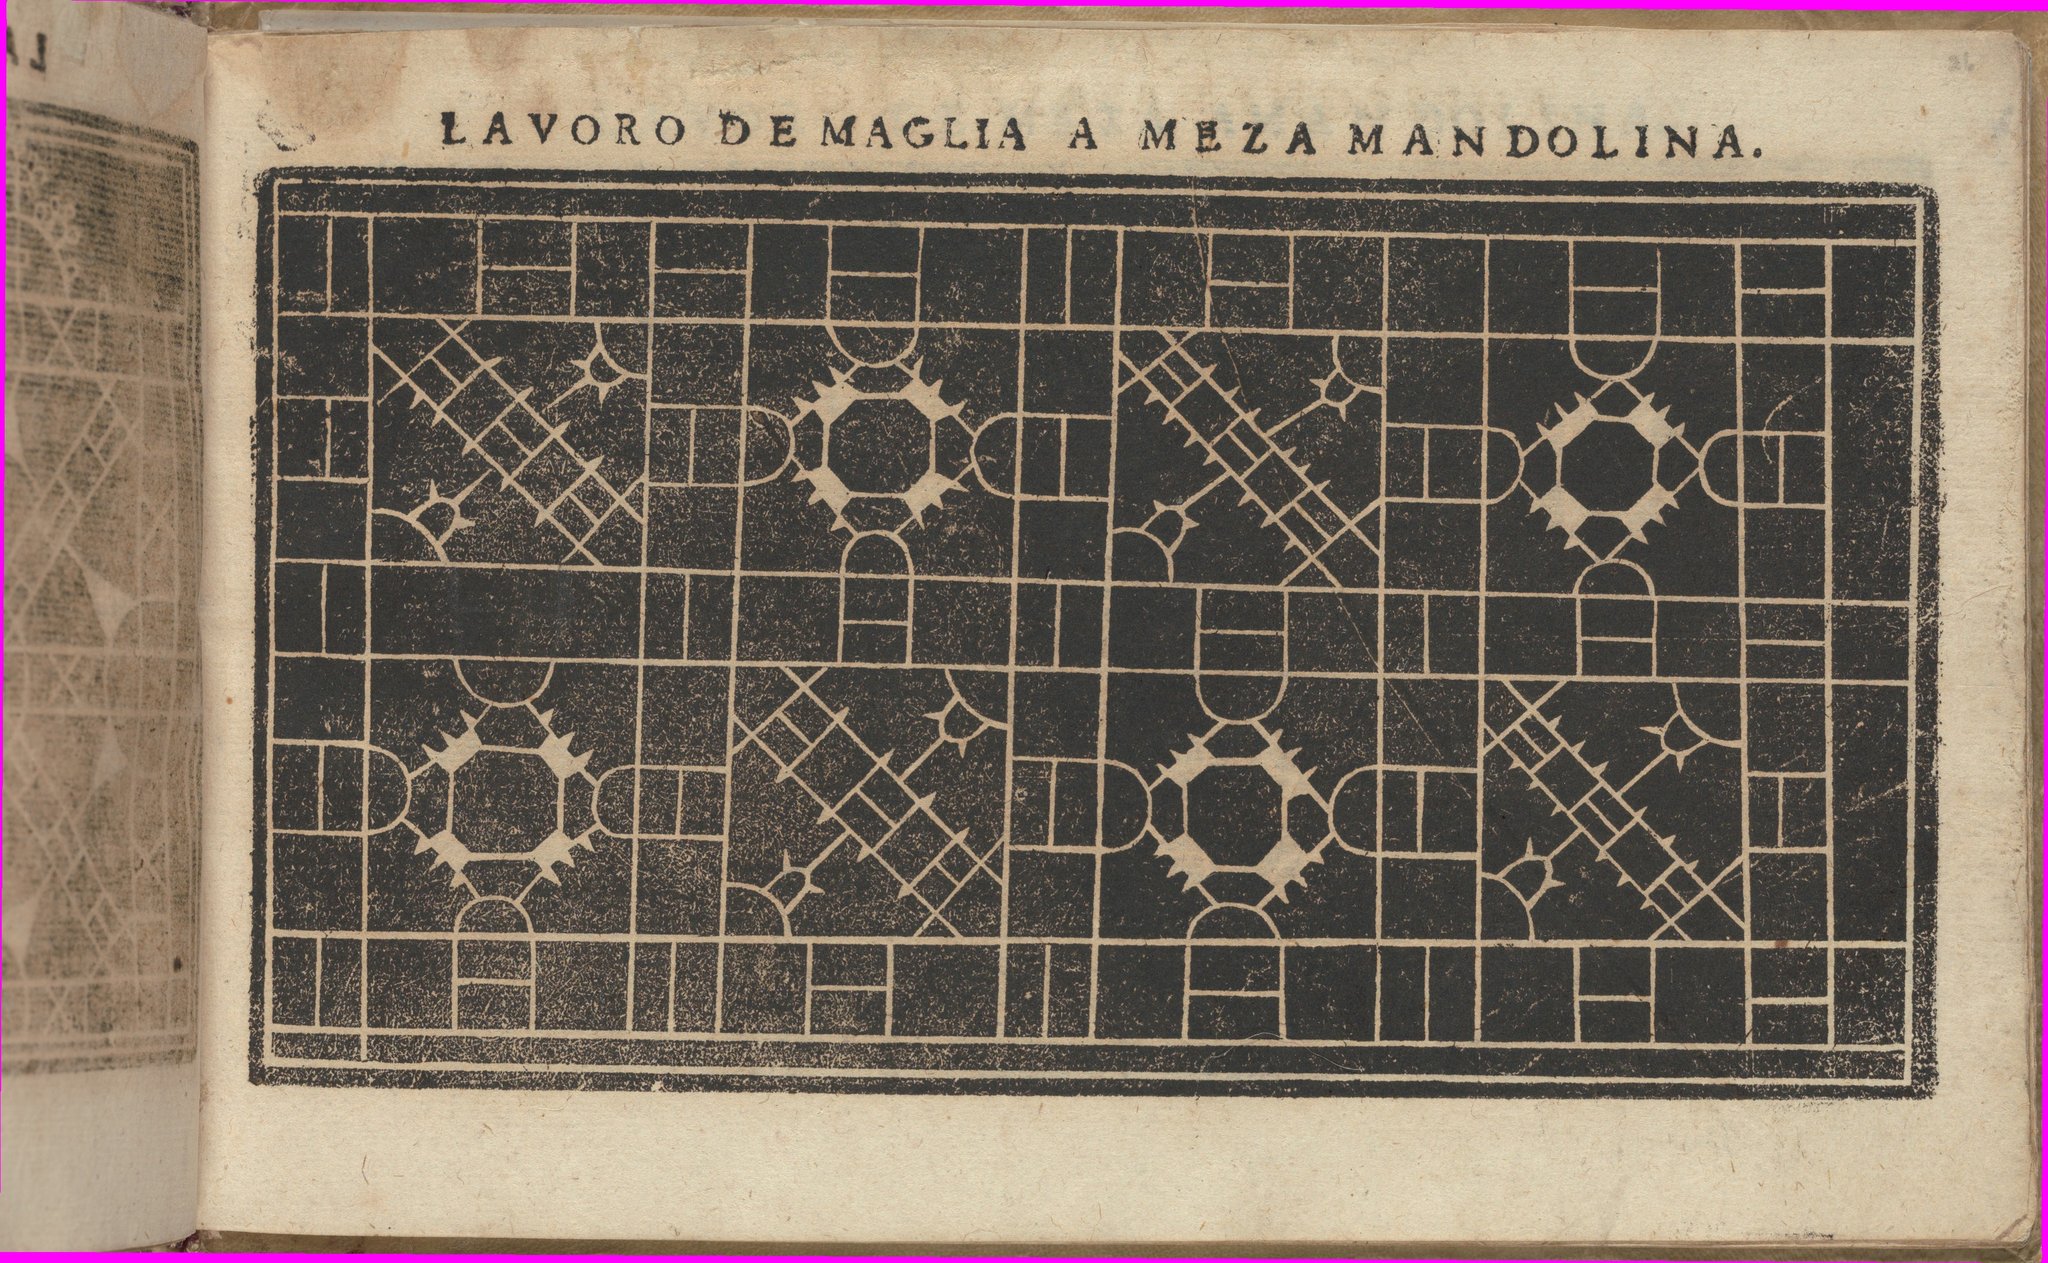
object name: book print ornament architecture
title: Studio delle virtuose Dame, page 26 (recto)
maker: isabella catanea parasole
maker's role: designer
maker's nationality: italian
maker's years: 1565-1625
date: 1597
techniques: woodcut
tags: ornament